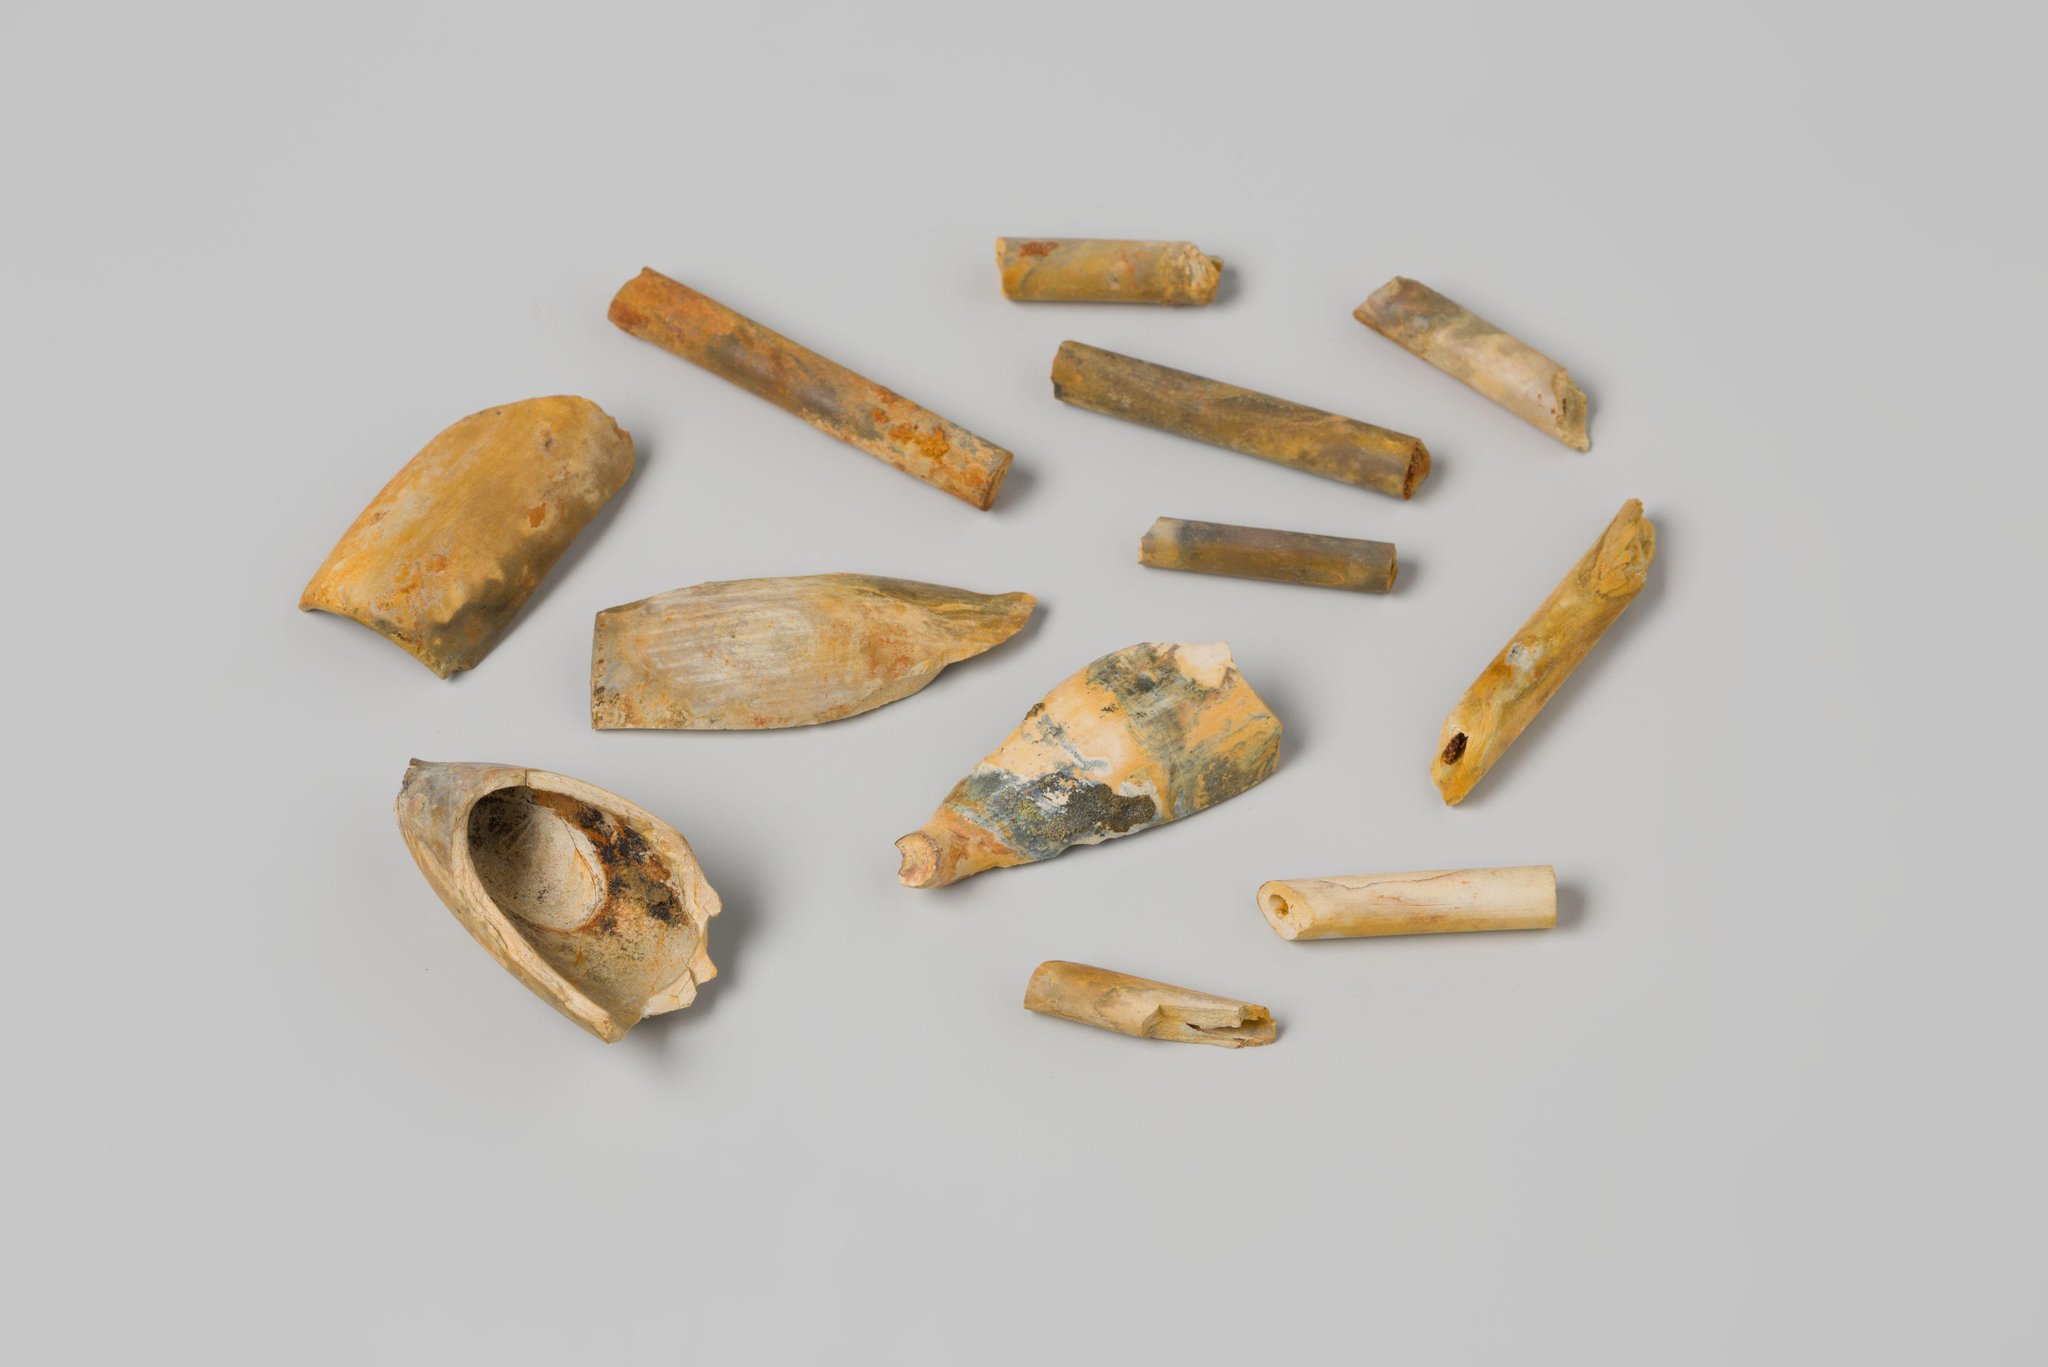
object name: pipe stem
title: Pijpenkoppen en -stelen uit het wrak van de Oost-Indiëvaarder 't Vliegend Hart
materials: clay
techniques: firing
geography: gouda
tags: 't vliegend hart (schip), verenigde oostindische compagnie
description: Vier fragmenten van koppen van aarden Goudse pijpen en acht stukken pijpensteel, geelblauw-metalig verkleurd.